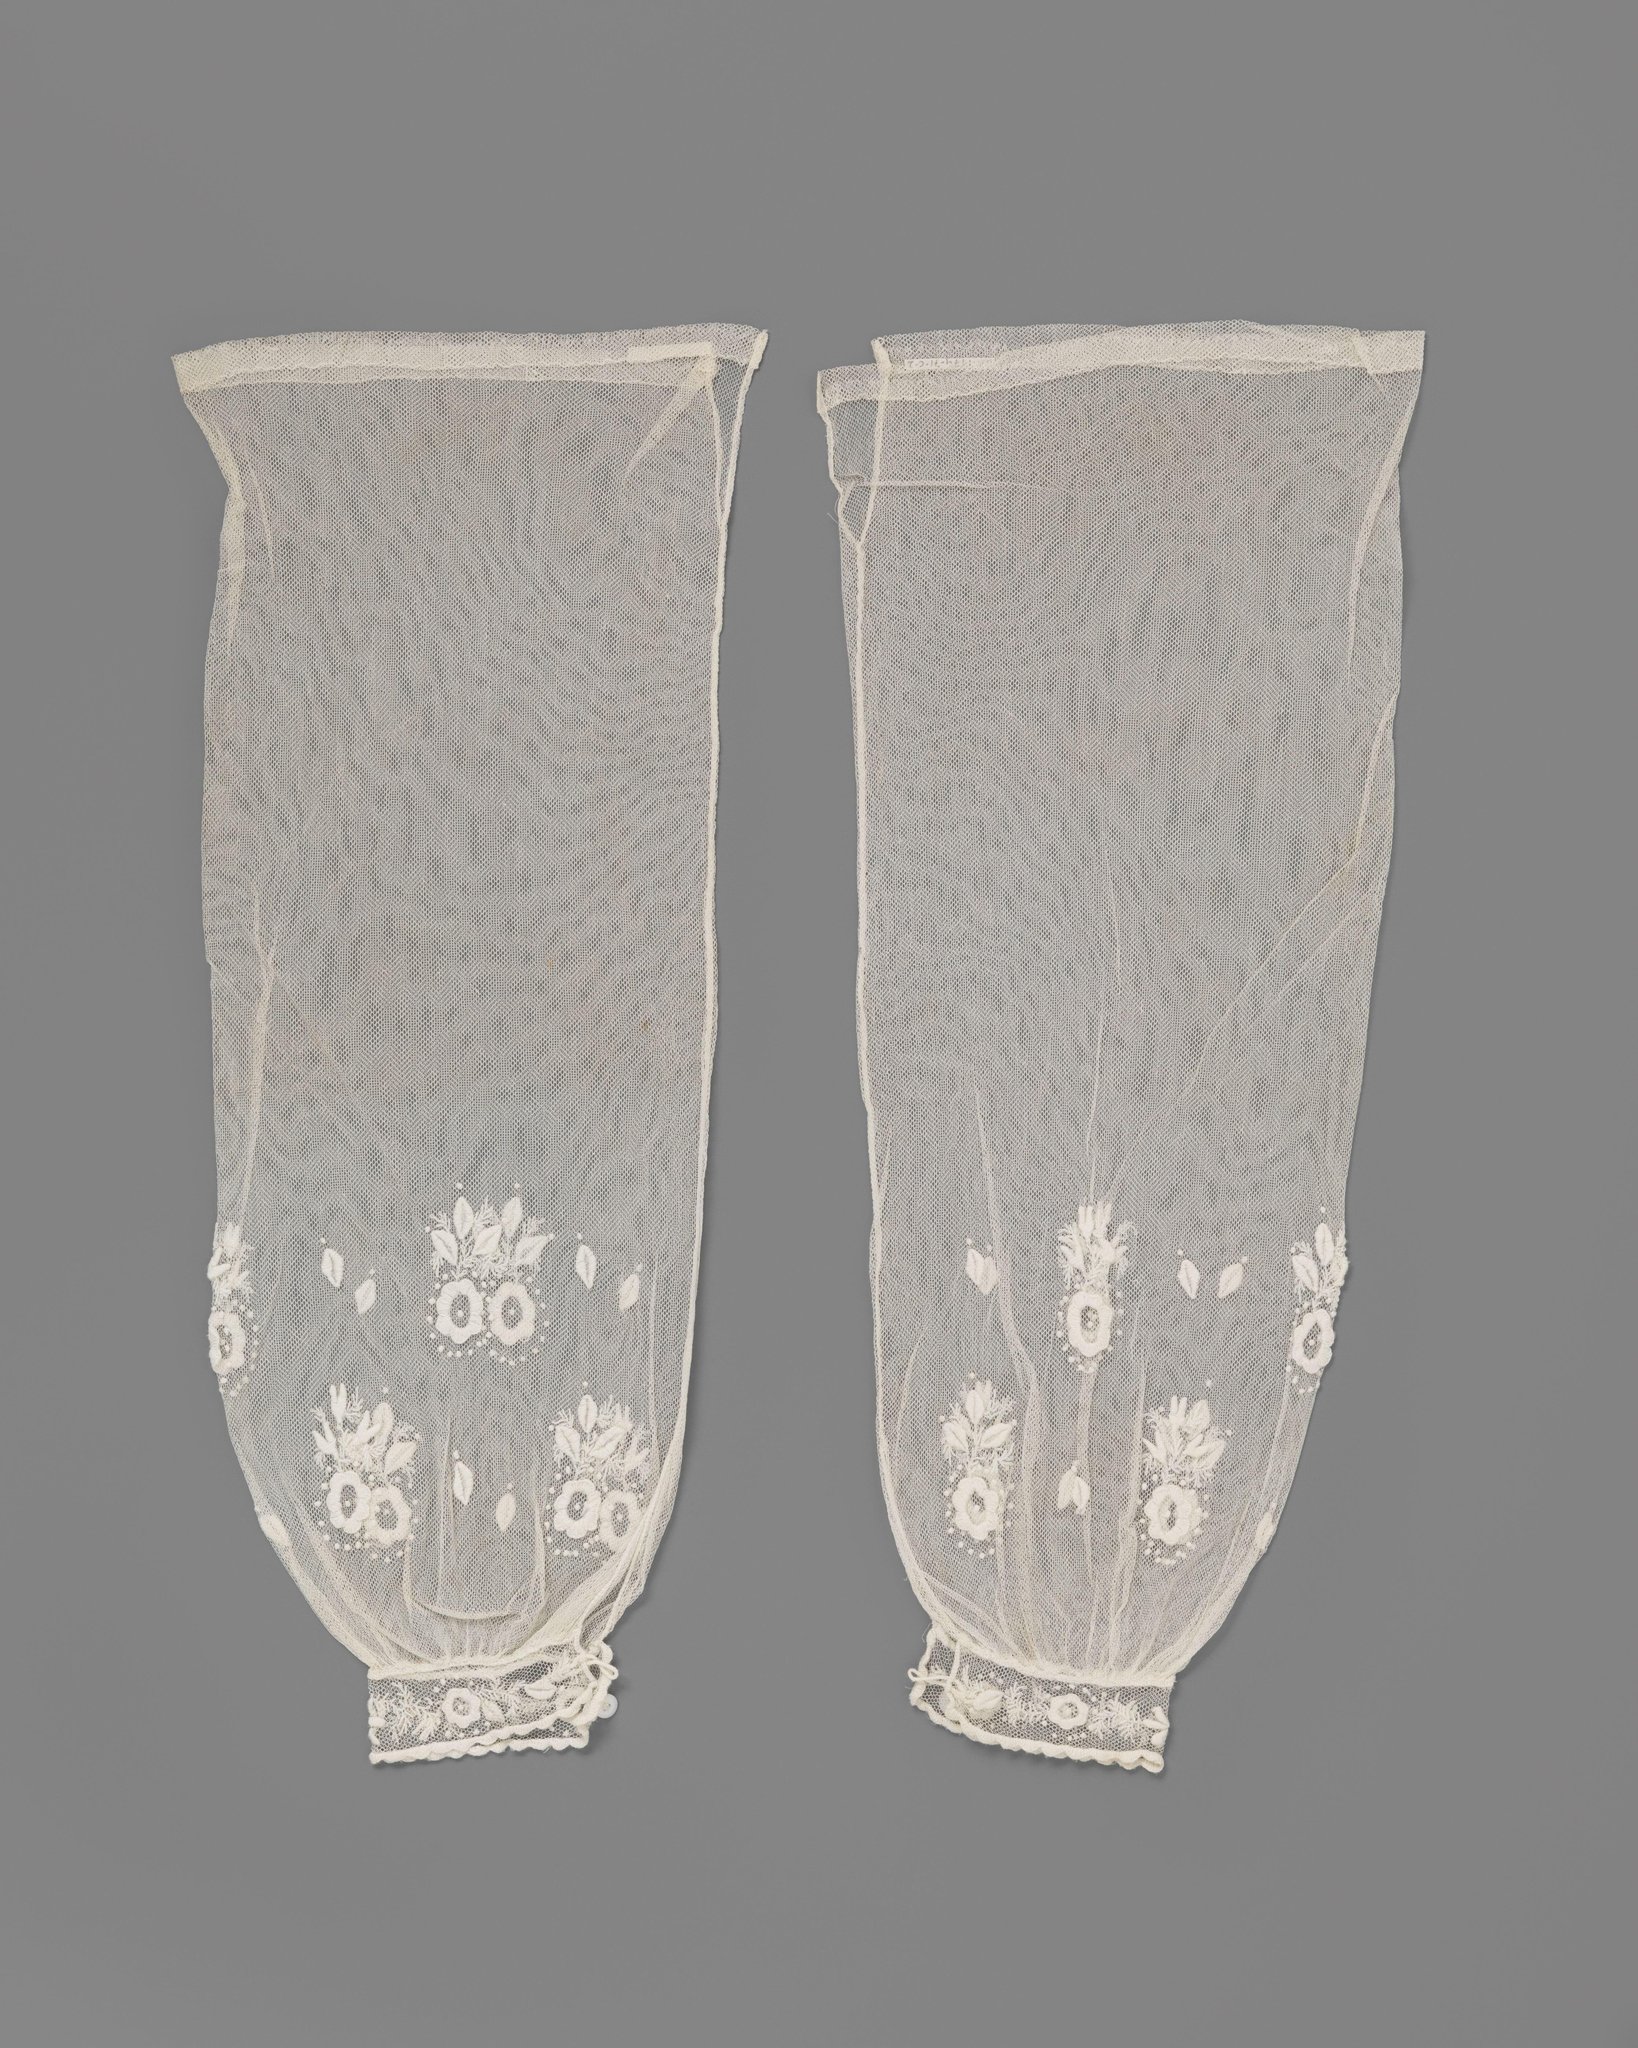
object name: undersleeve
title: Ondermouw met borduursel van rozen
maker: Anonymous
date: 1860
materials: glass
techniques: cockled, embroidered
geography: netherlands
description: Ondermouw van tule, die gerimpeld aan de manchet is bevestigd. De mouw en de manchet zijn beiden versierd met wit borduurwerk in de vorm van bloemen en bladeren. De manchet is afgezet met een geschulpte rand, en kan worden gesloten met een glazen knoop.